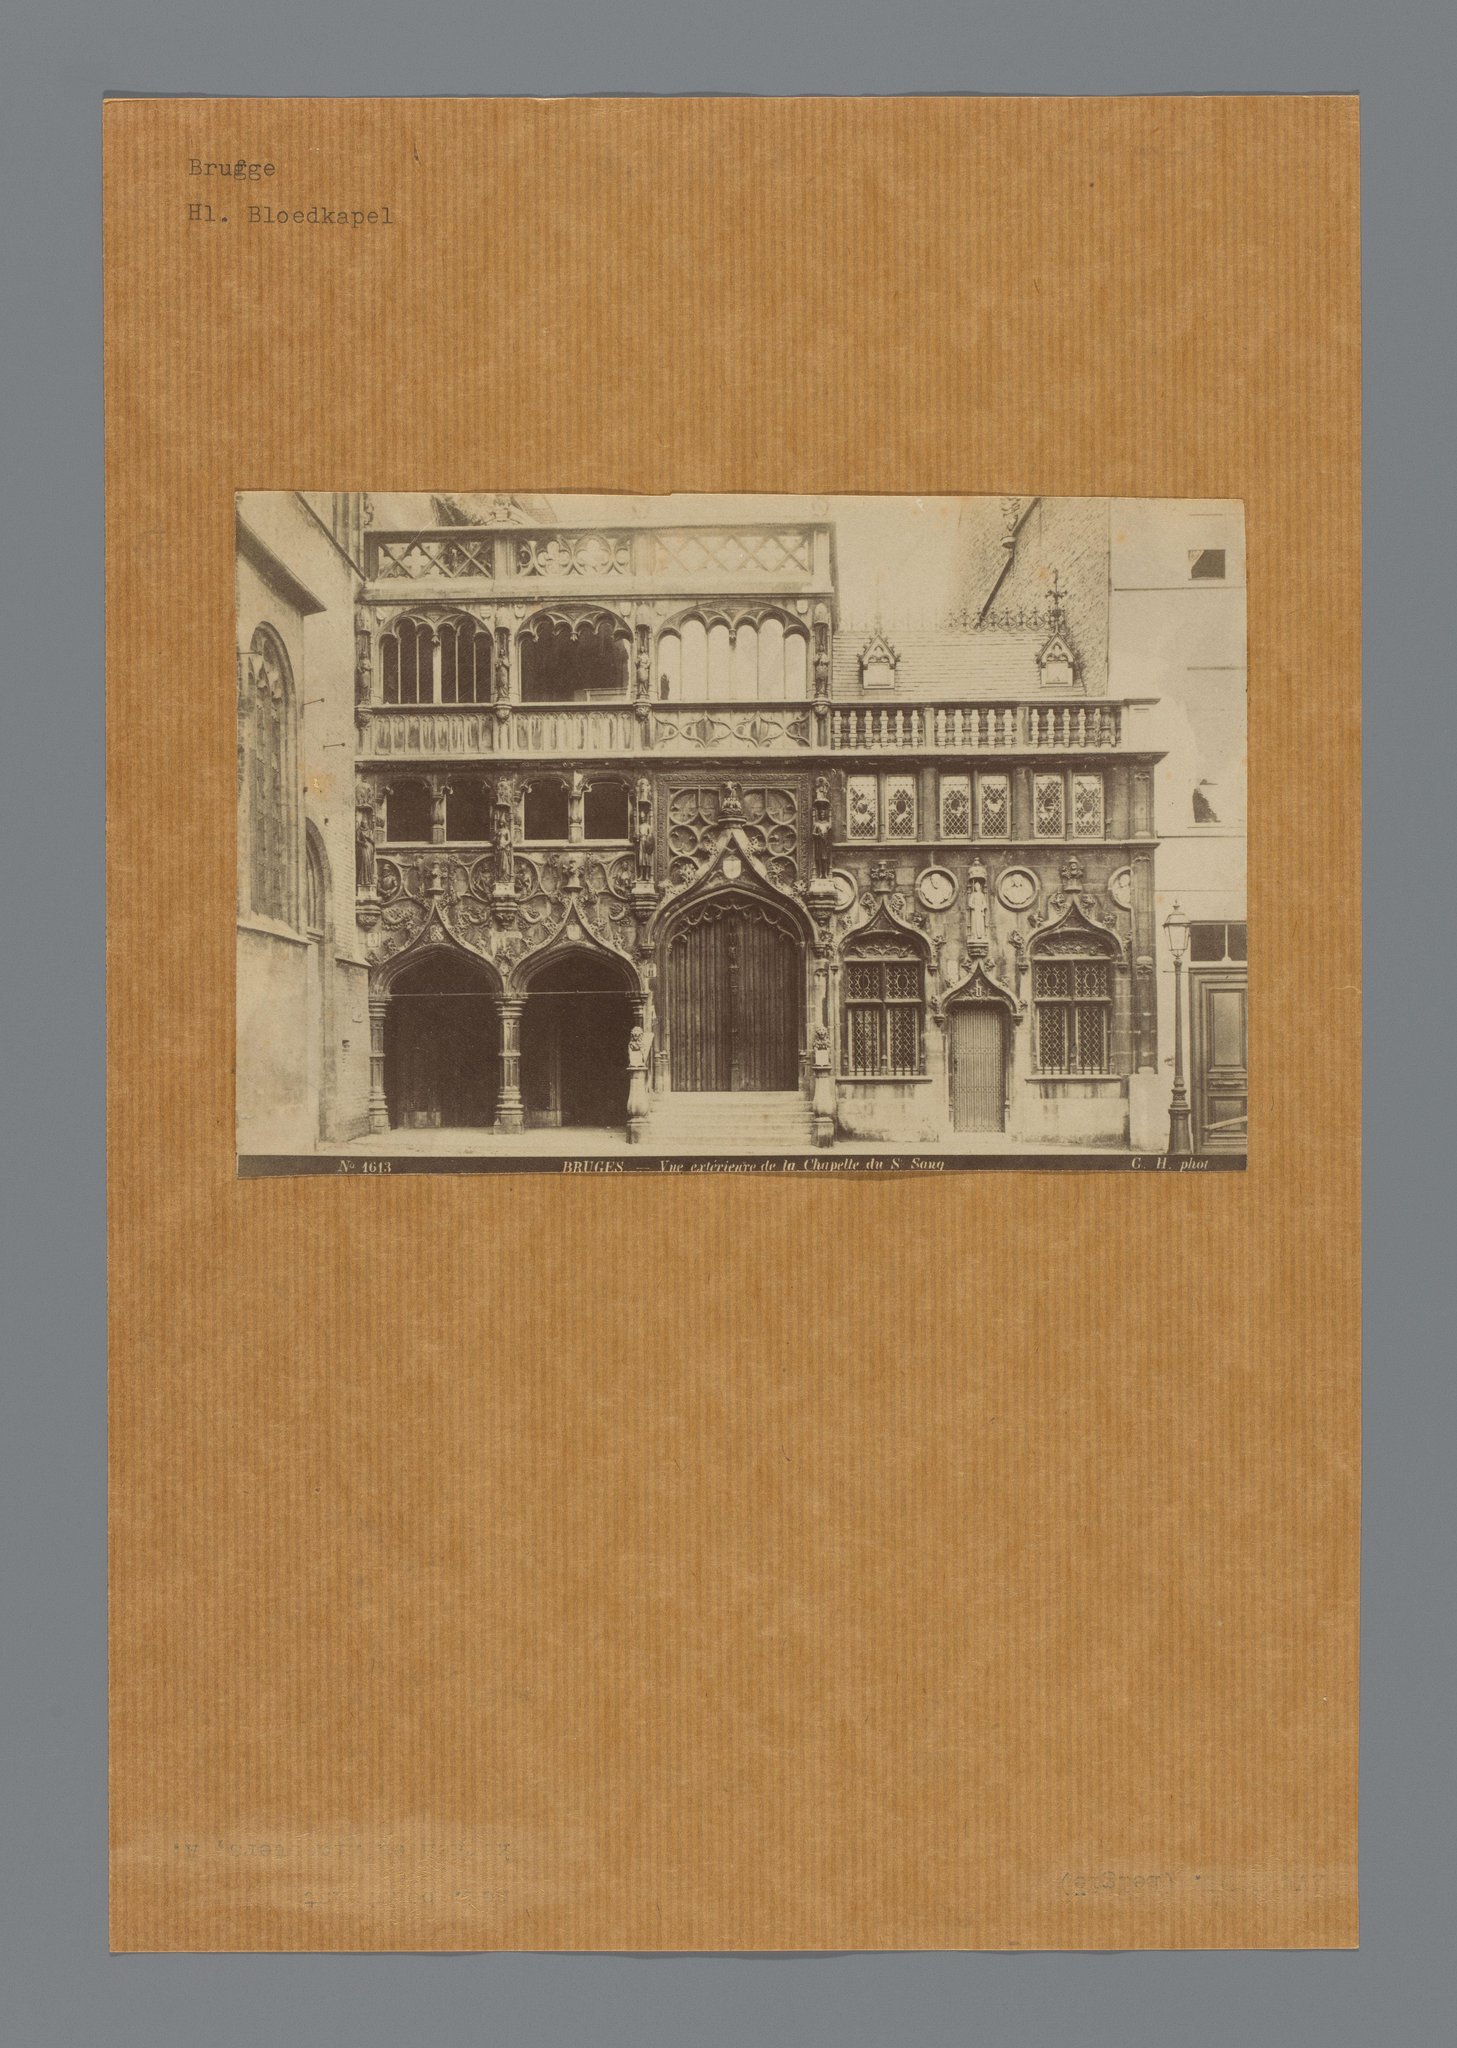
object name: photograph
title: Brugge. Chapelle de S.Sang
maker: Anonymous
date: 1850-1900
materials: photographic support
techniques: albumen print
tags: bruges